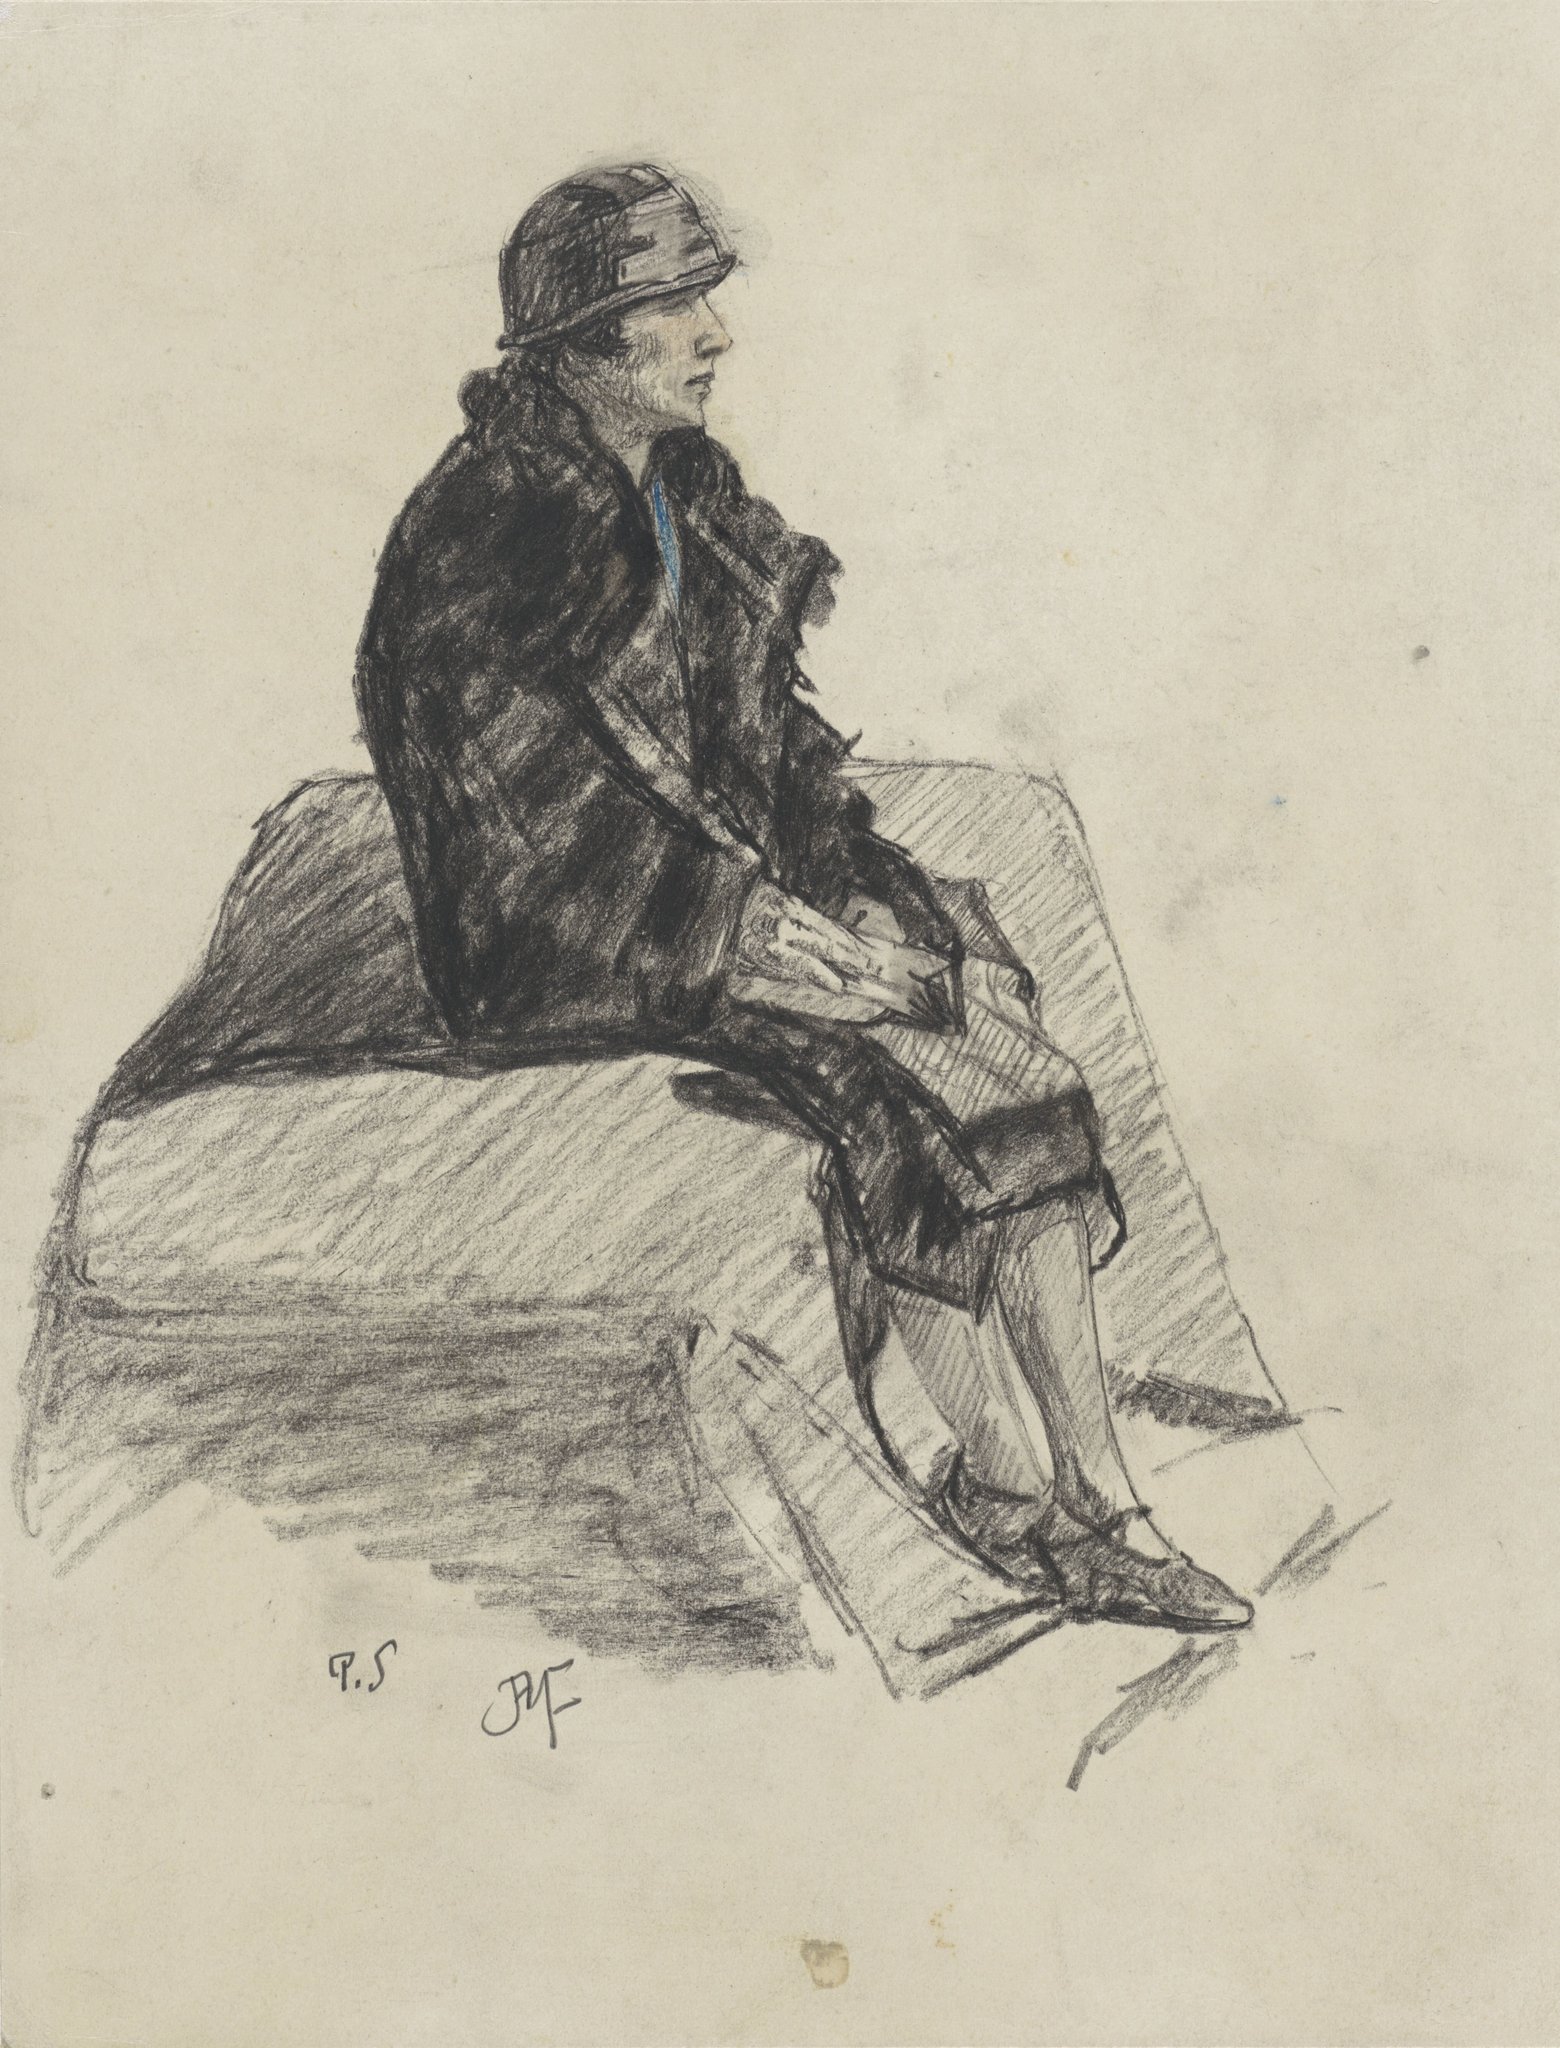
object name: drawing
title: Vrouw zittend op een divan, en profil naar rechts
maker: johannes abraham mondt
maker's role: draughtsman, print maker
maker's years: 1859-1941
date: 1869-1941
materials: chalk, paper